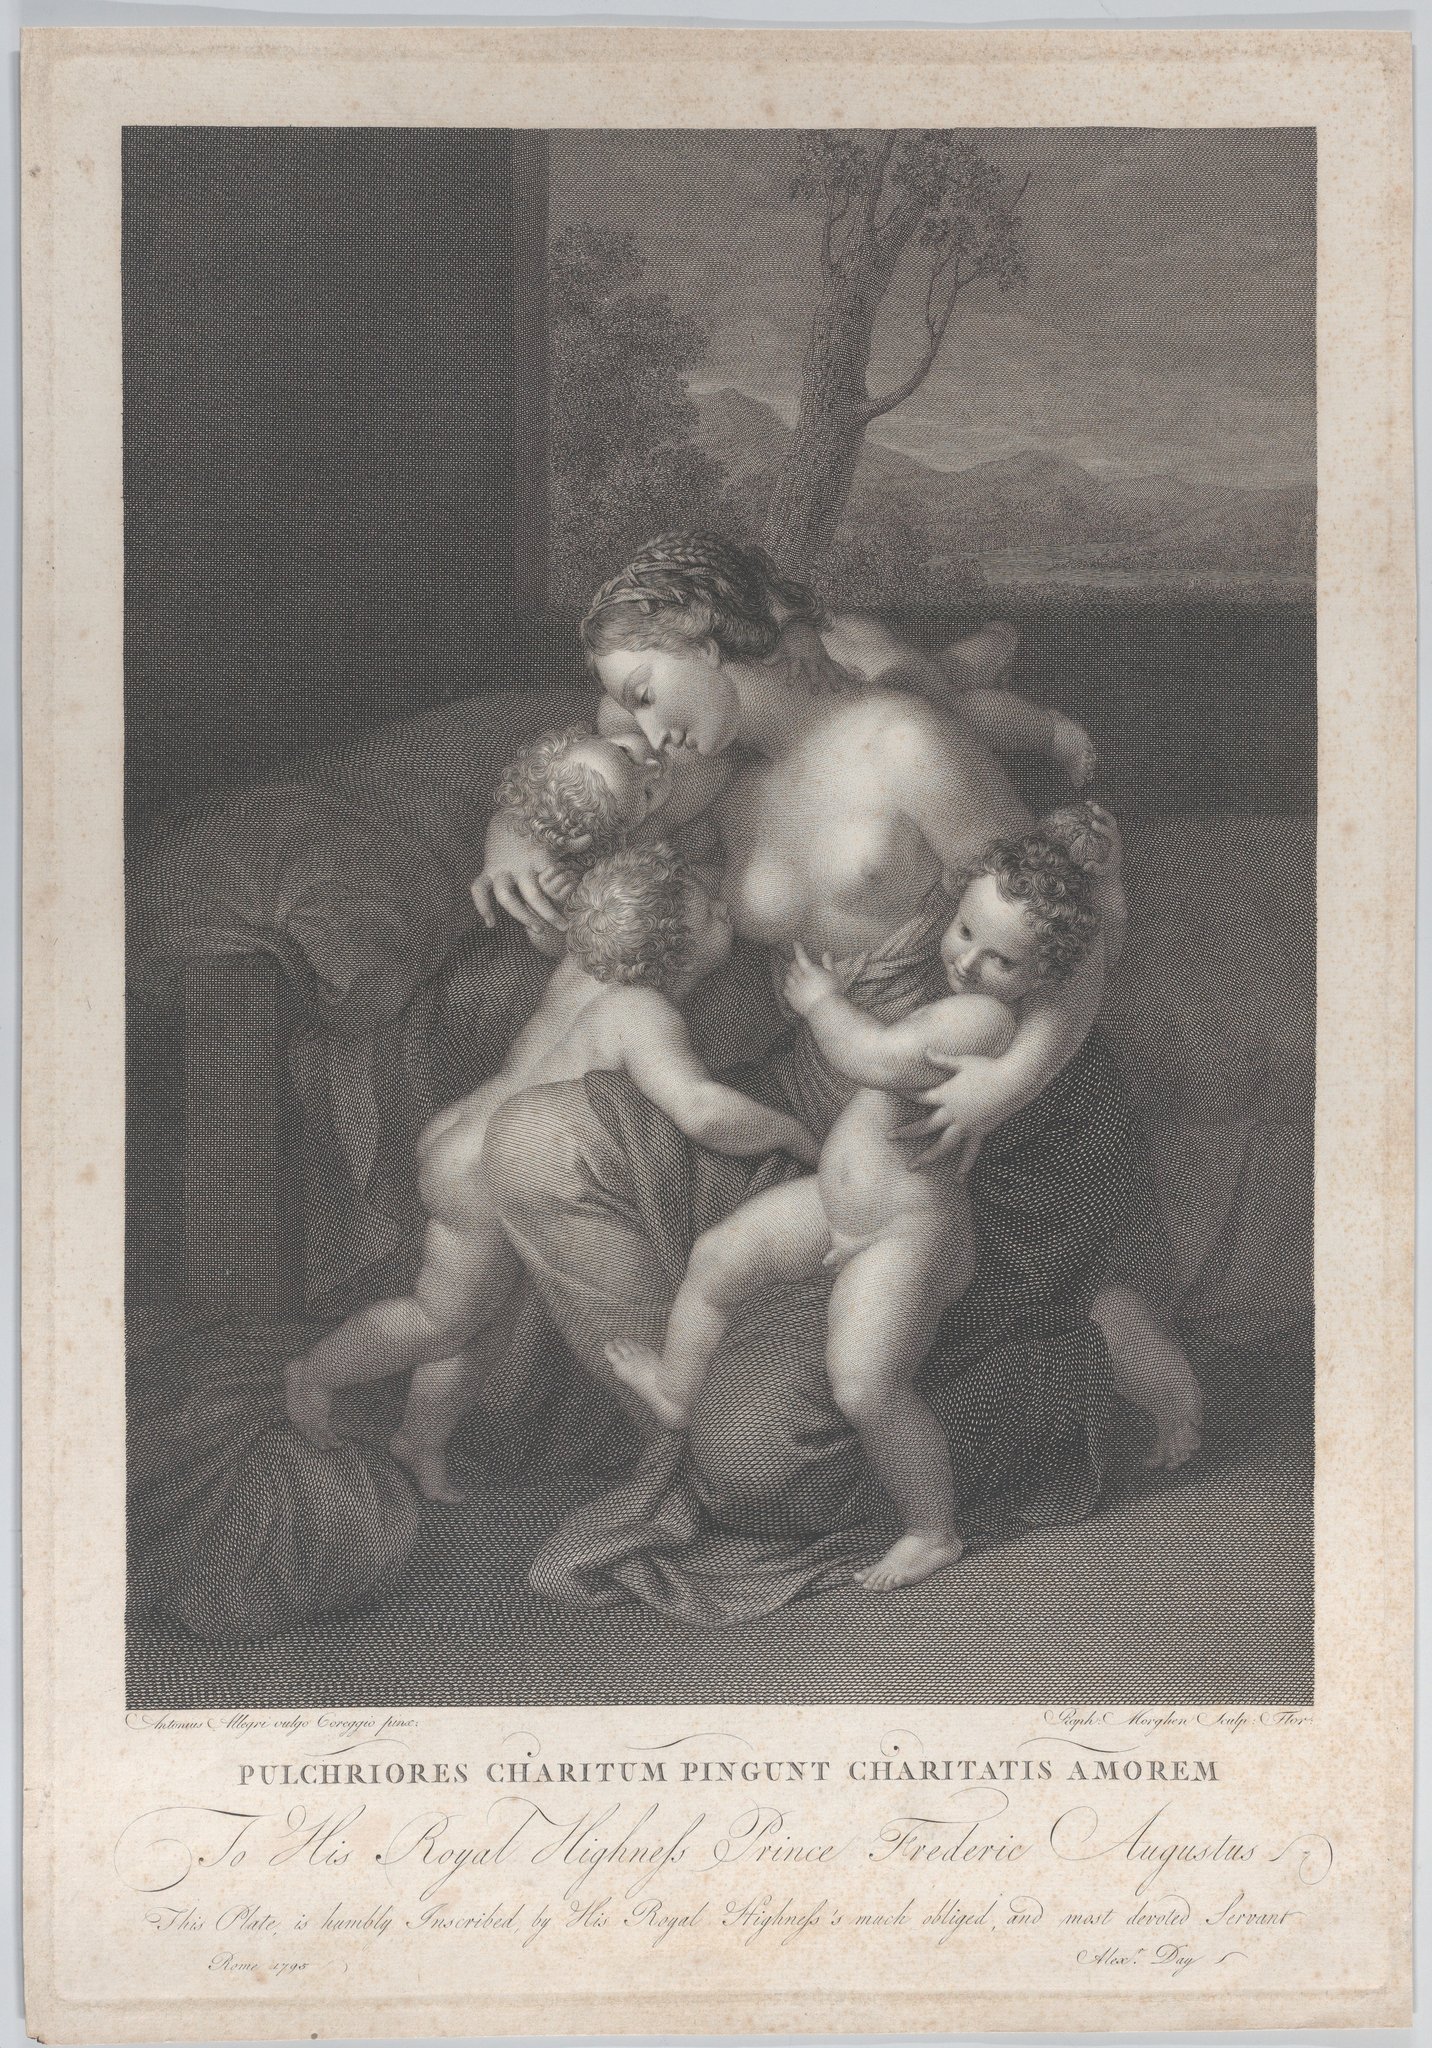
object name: print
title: Charity with three small children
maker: raphael morghen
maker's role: artist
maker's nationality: italian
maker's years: 1758-1833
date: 1795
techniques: engraving